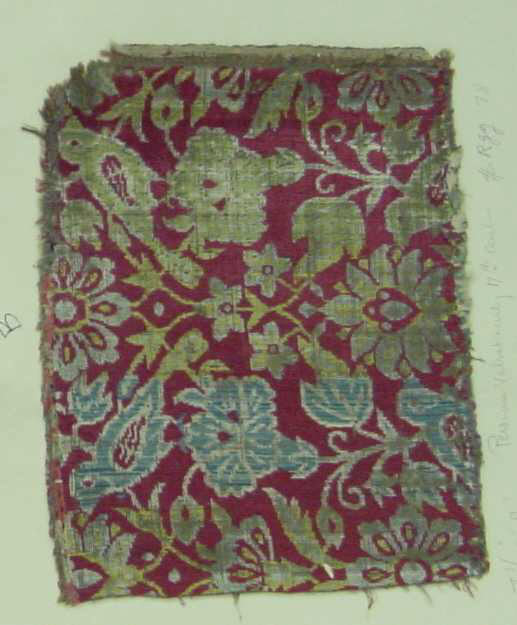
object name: textile fragment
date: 1601-1633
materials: velvet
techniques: cutting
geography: iran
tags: birds,flowers,leaves